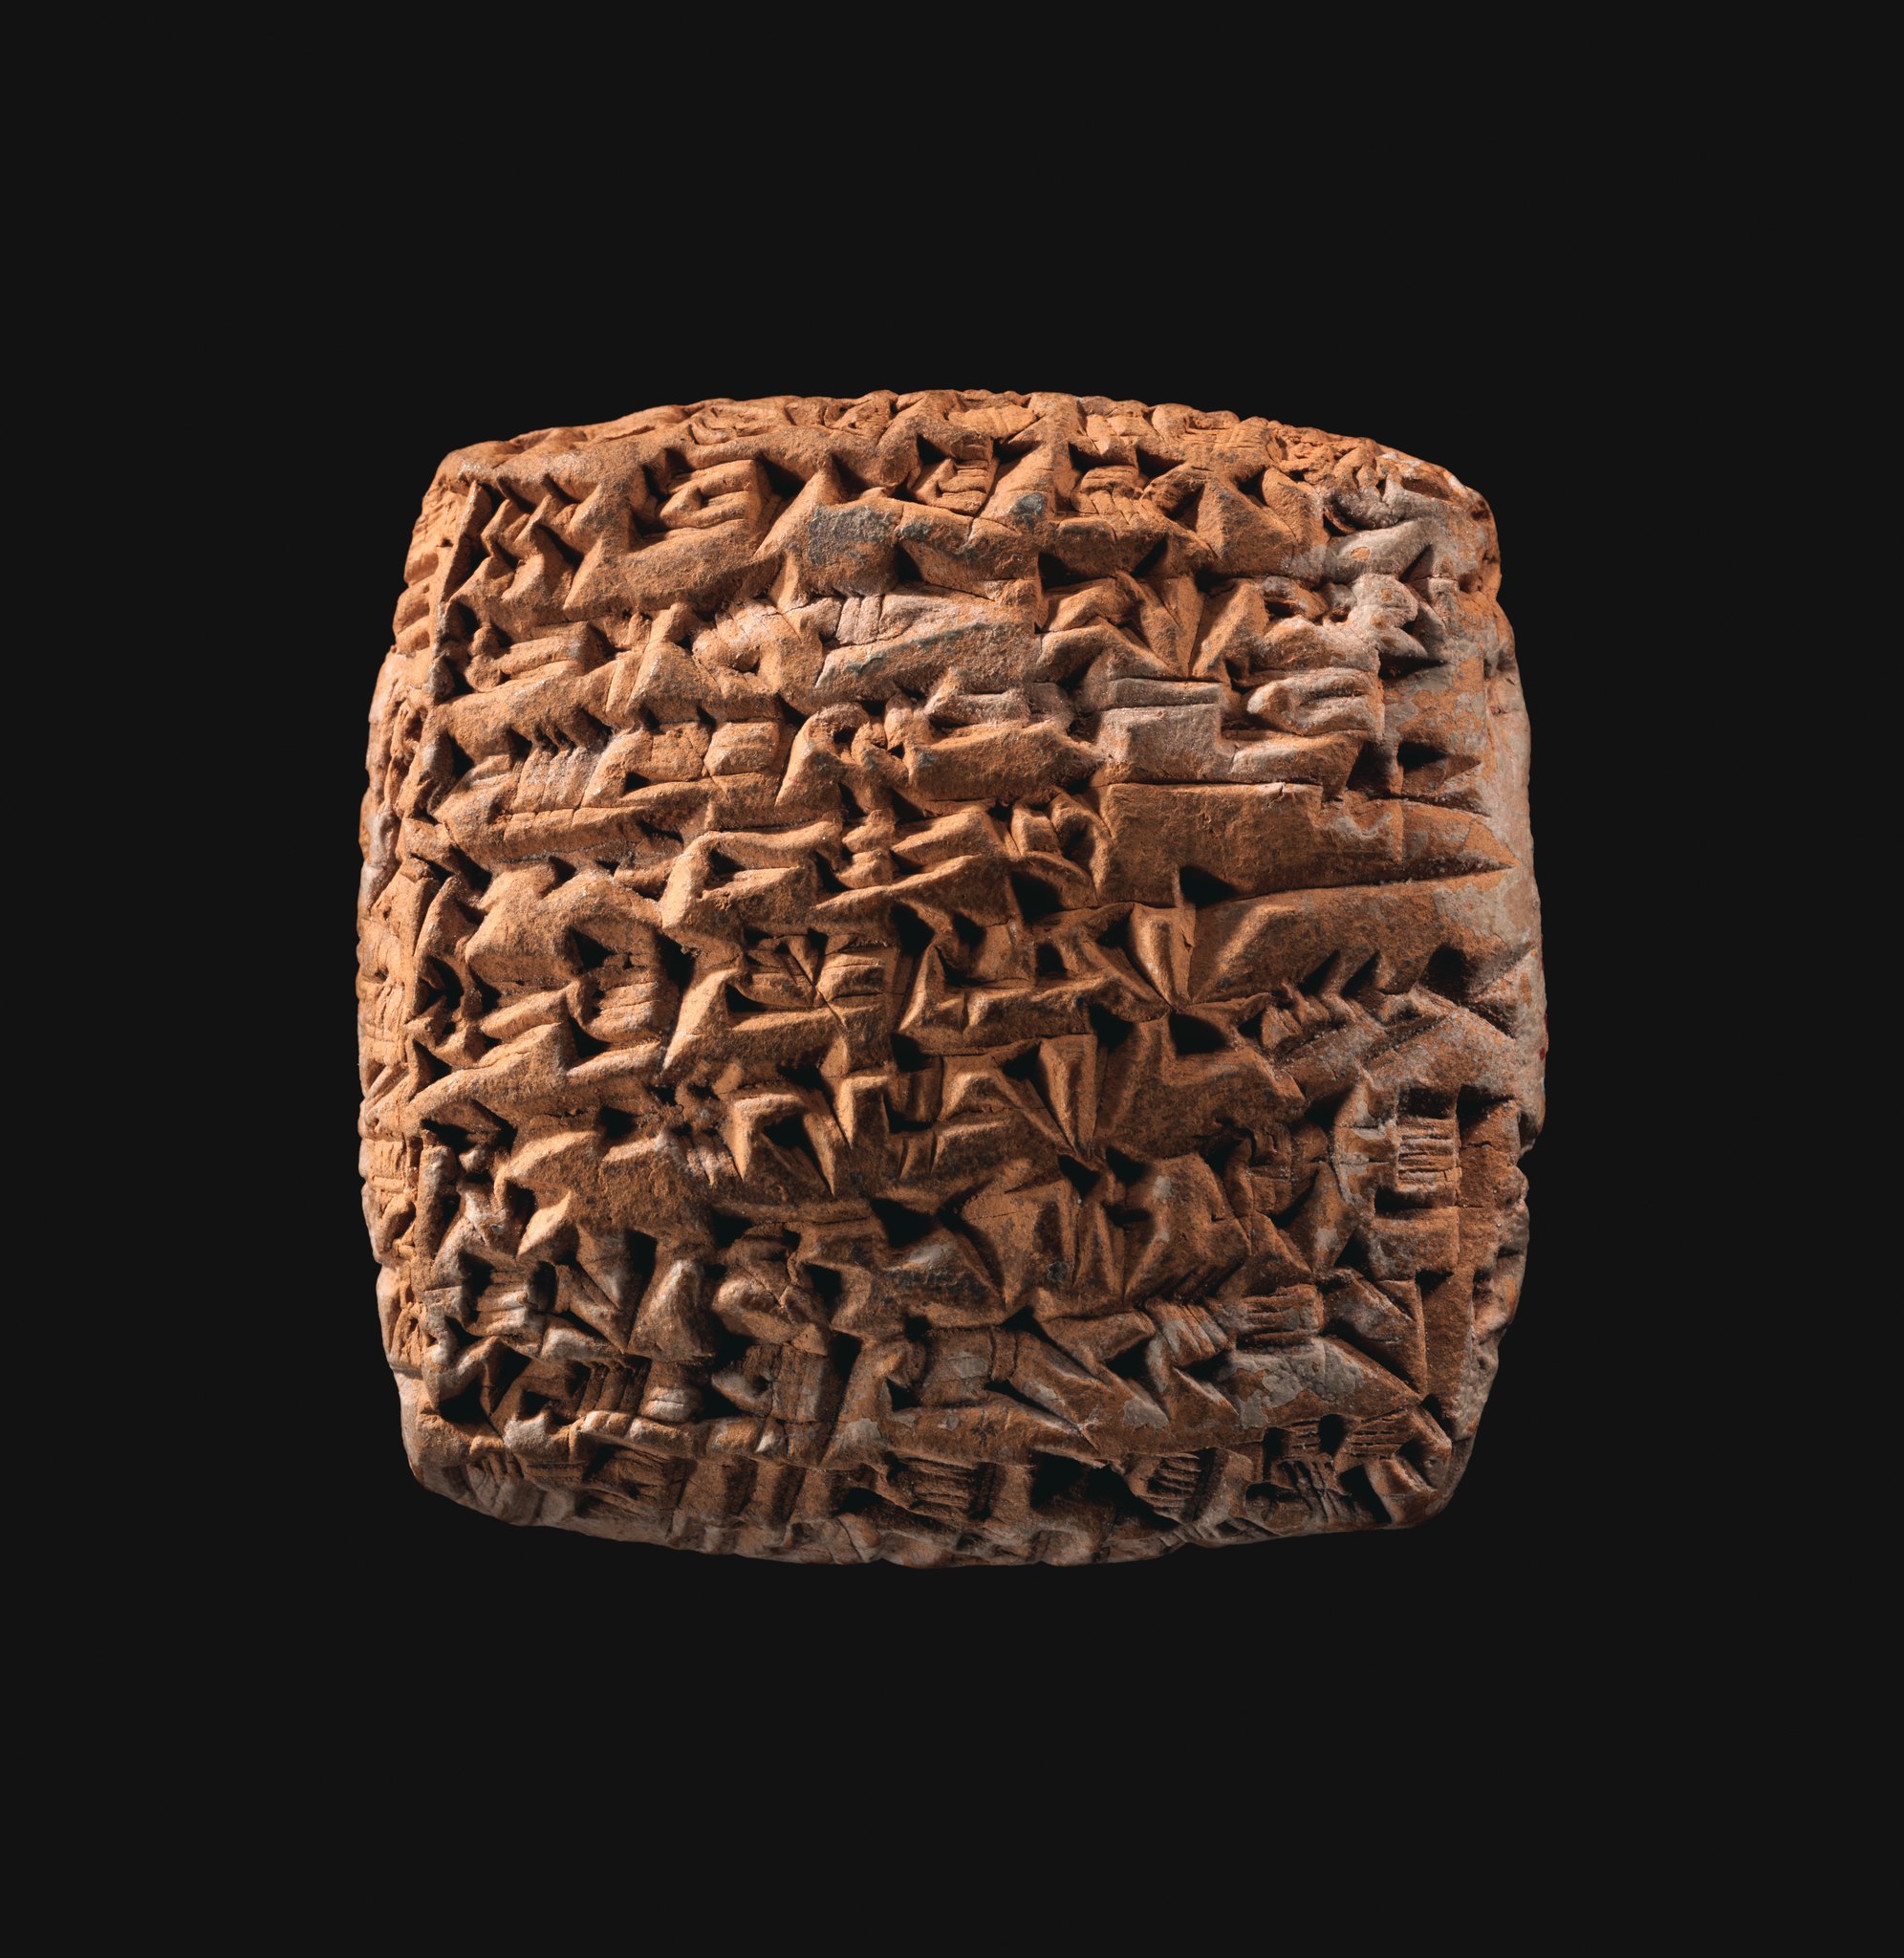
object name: cuneiform tablet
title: Cuneiform tablet: loan of silver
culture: assyrian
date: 2000-1801 BCE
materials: clay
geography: anatolia